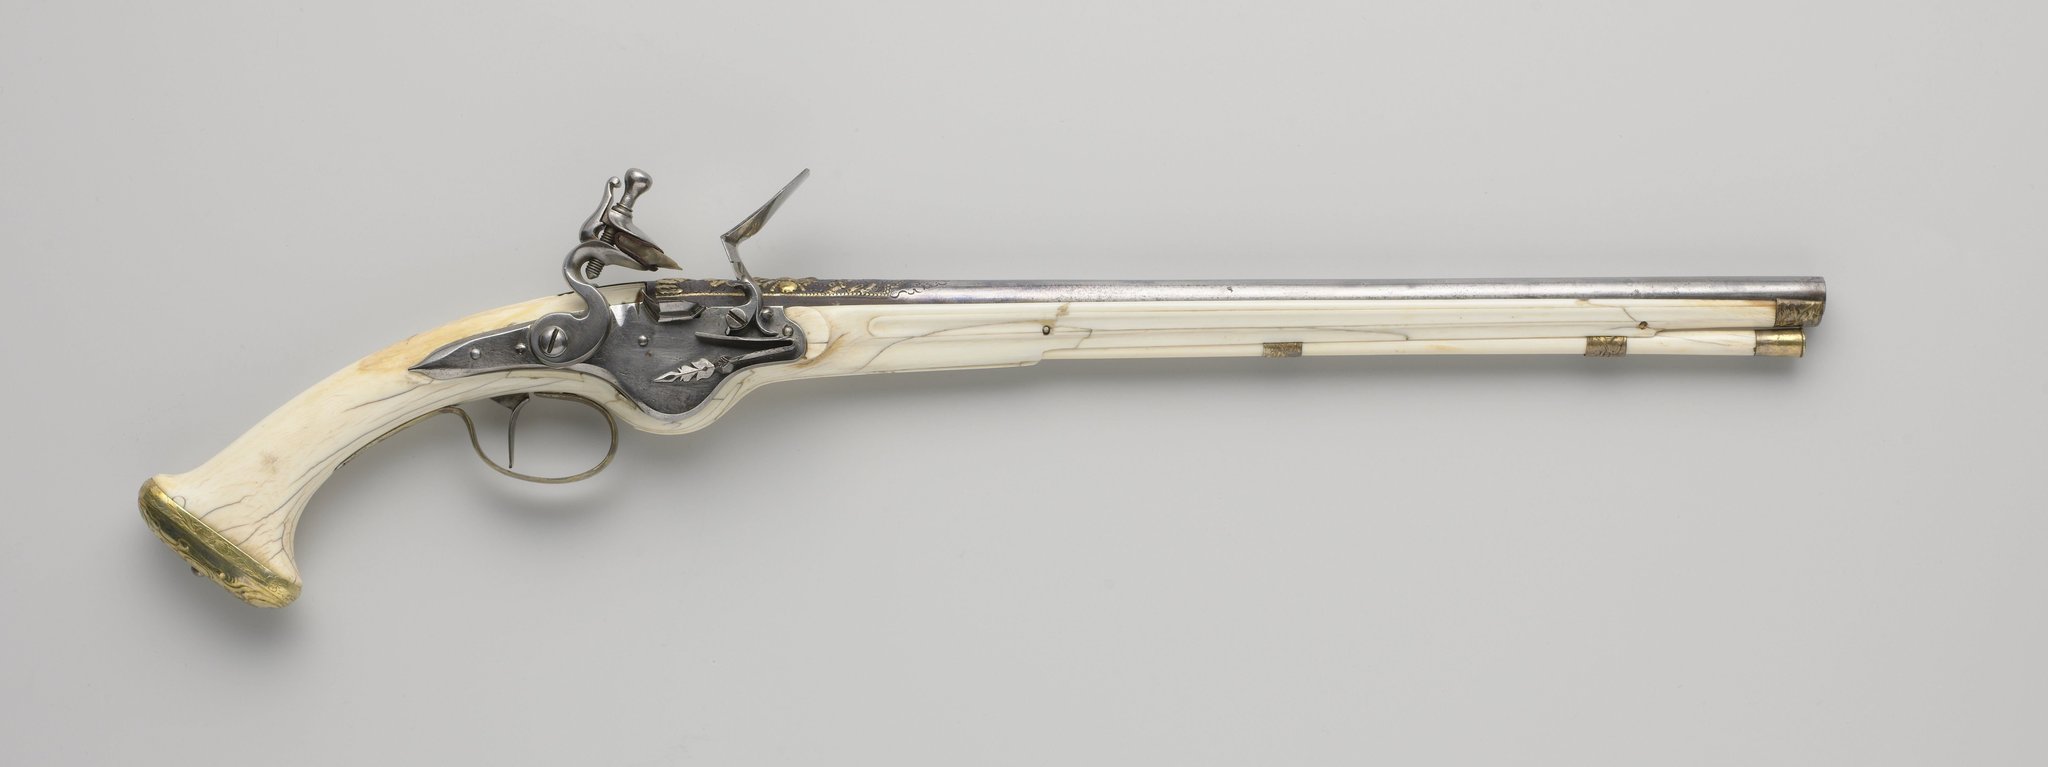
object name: flintlock pistol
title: Vuursteenpistool met ivoren lade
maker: Anonymous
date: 1655-1660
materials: brass, ivory, silver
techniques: cutting, encrustation, gilding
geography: netherlands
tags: netherlands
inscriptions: mark